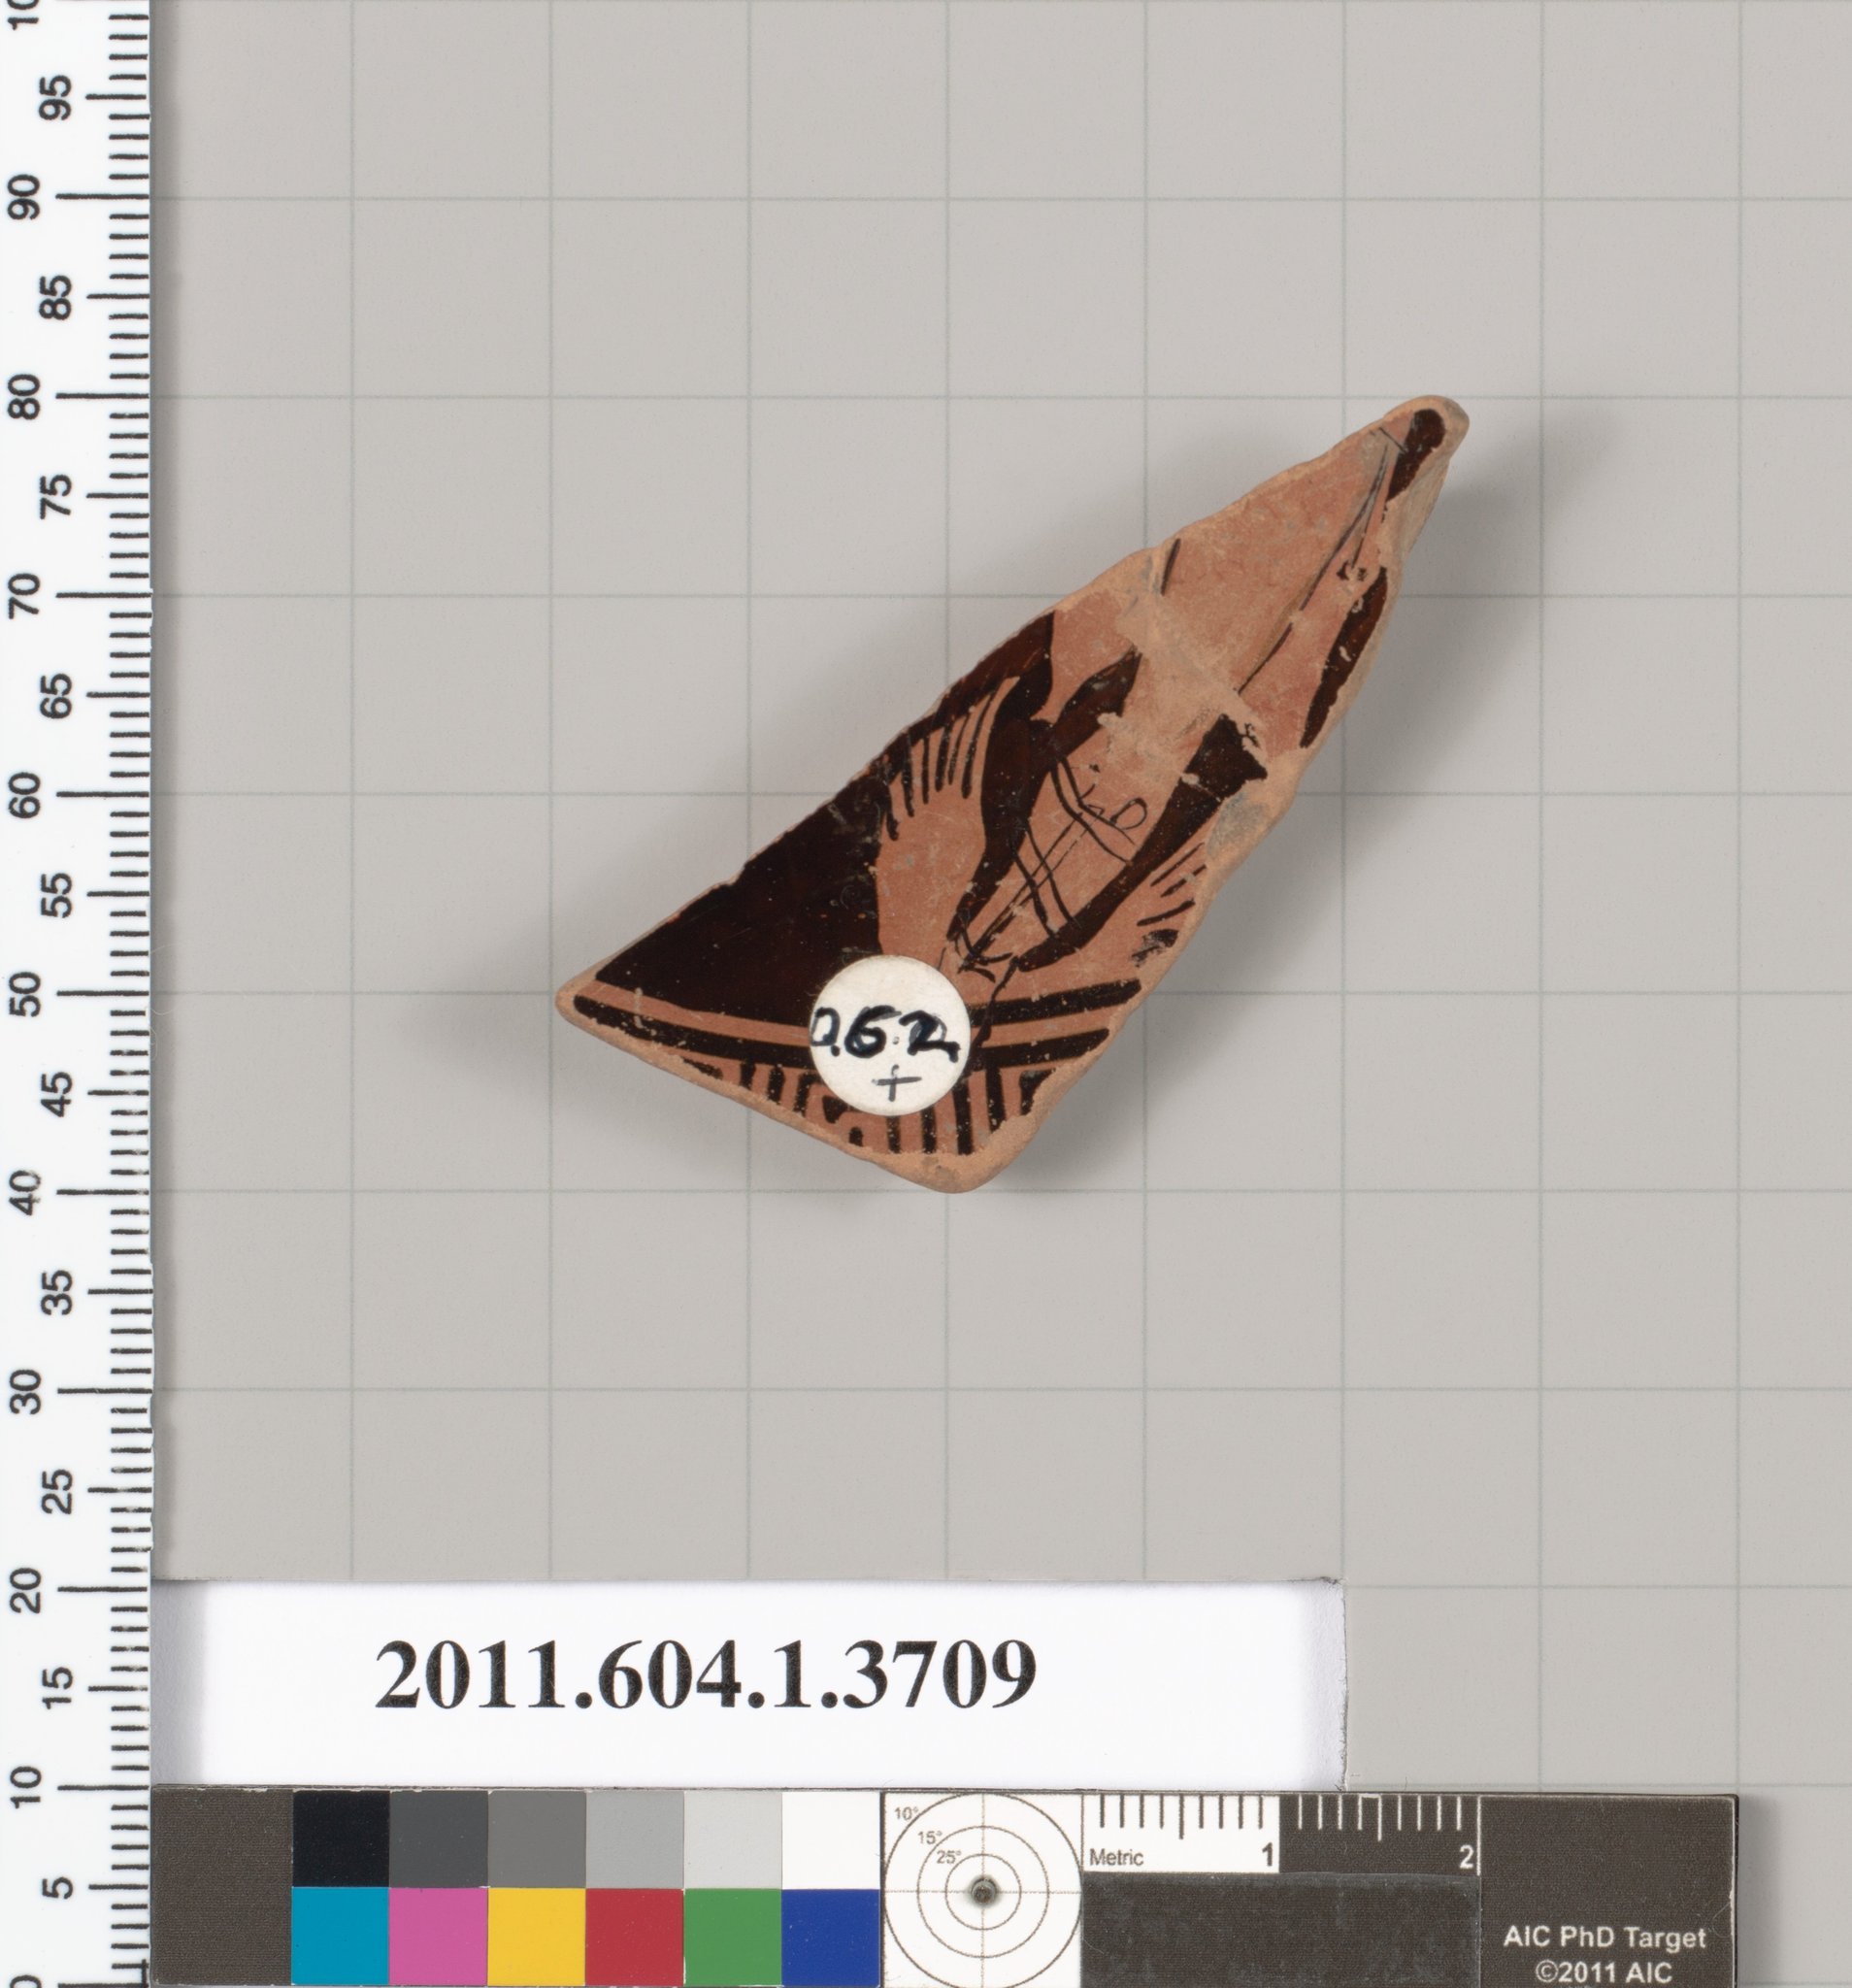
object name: kylix fragment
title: Terracotta fragment of a kylix (drinking cup)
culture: greek, attic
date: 490-470 BCE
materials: terracotta